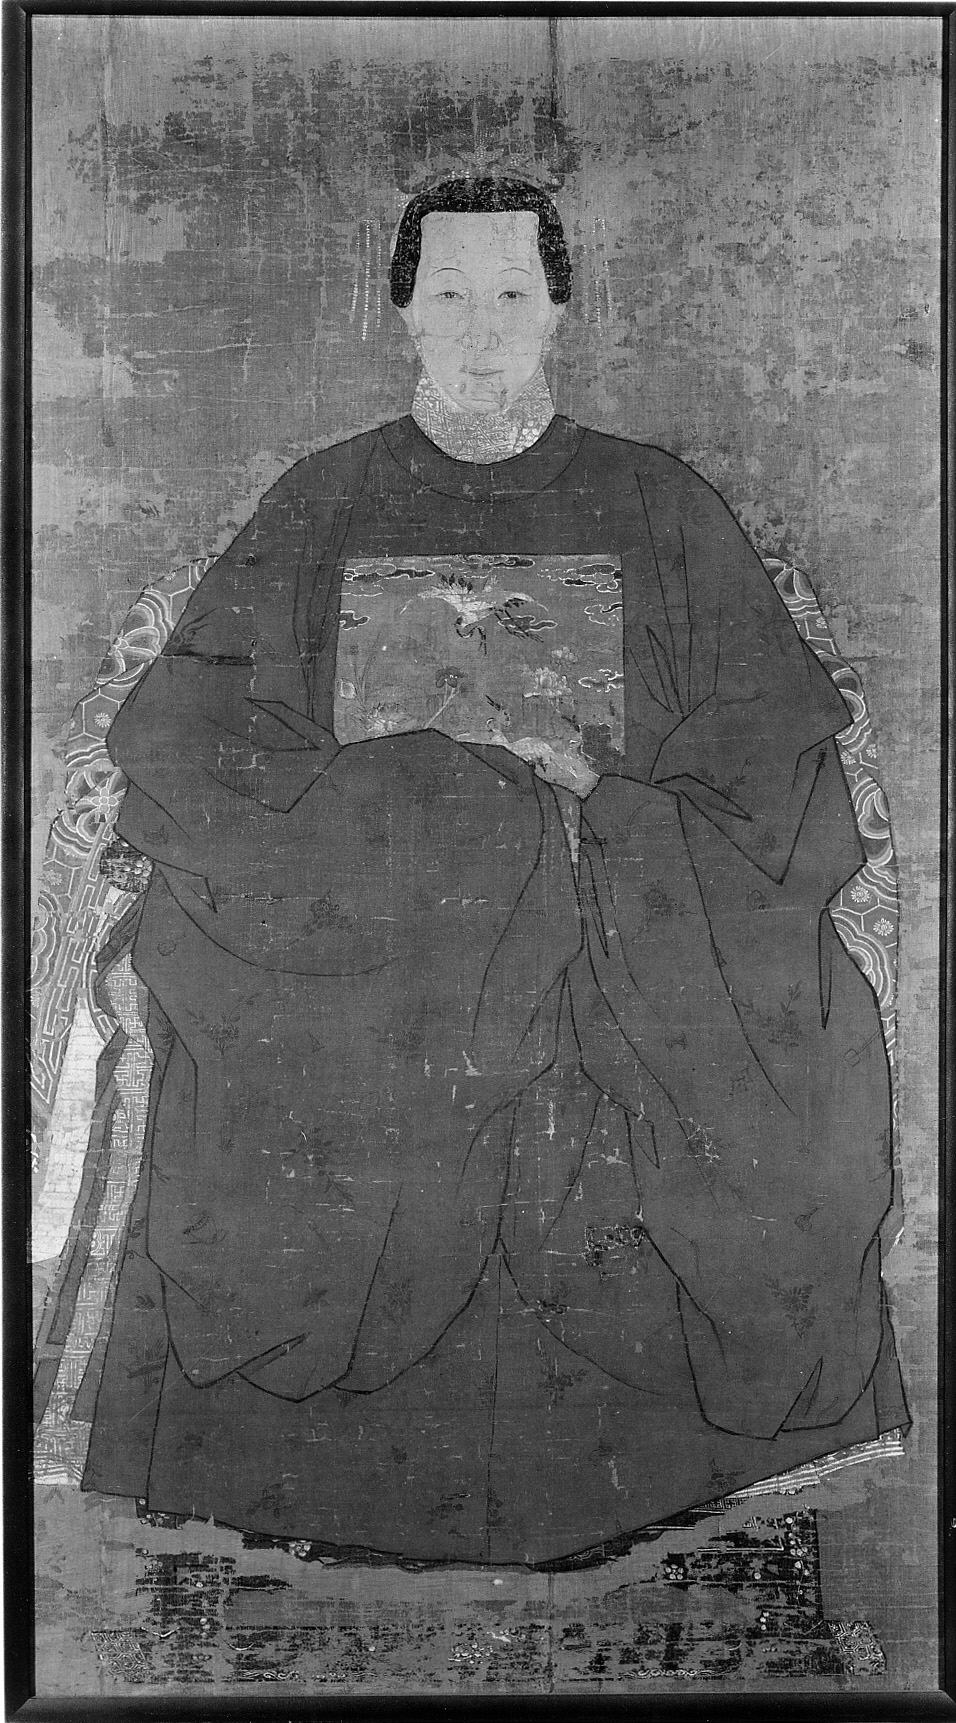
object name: hanging scroll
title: Portrait of a Lady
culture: chinese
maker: unidentified artist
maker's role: artist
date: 1567-1633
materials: ink, silk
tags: portraits,women